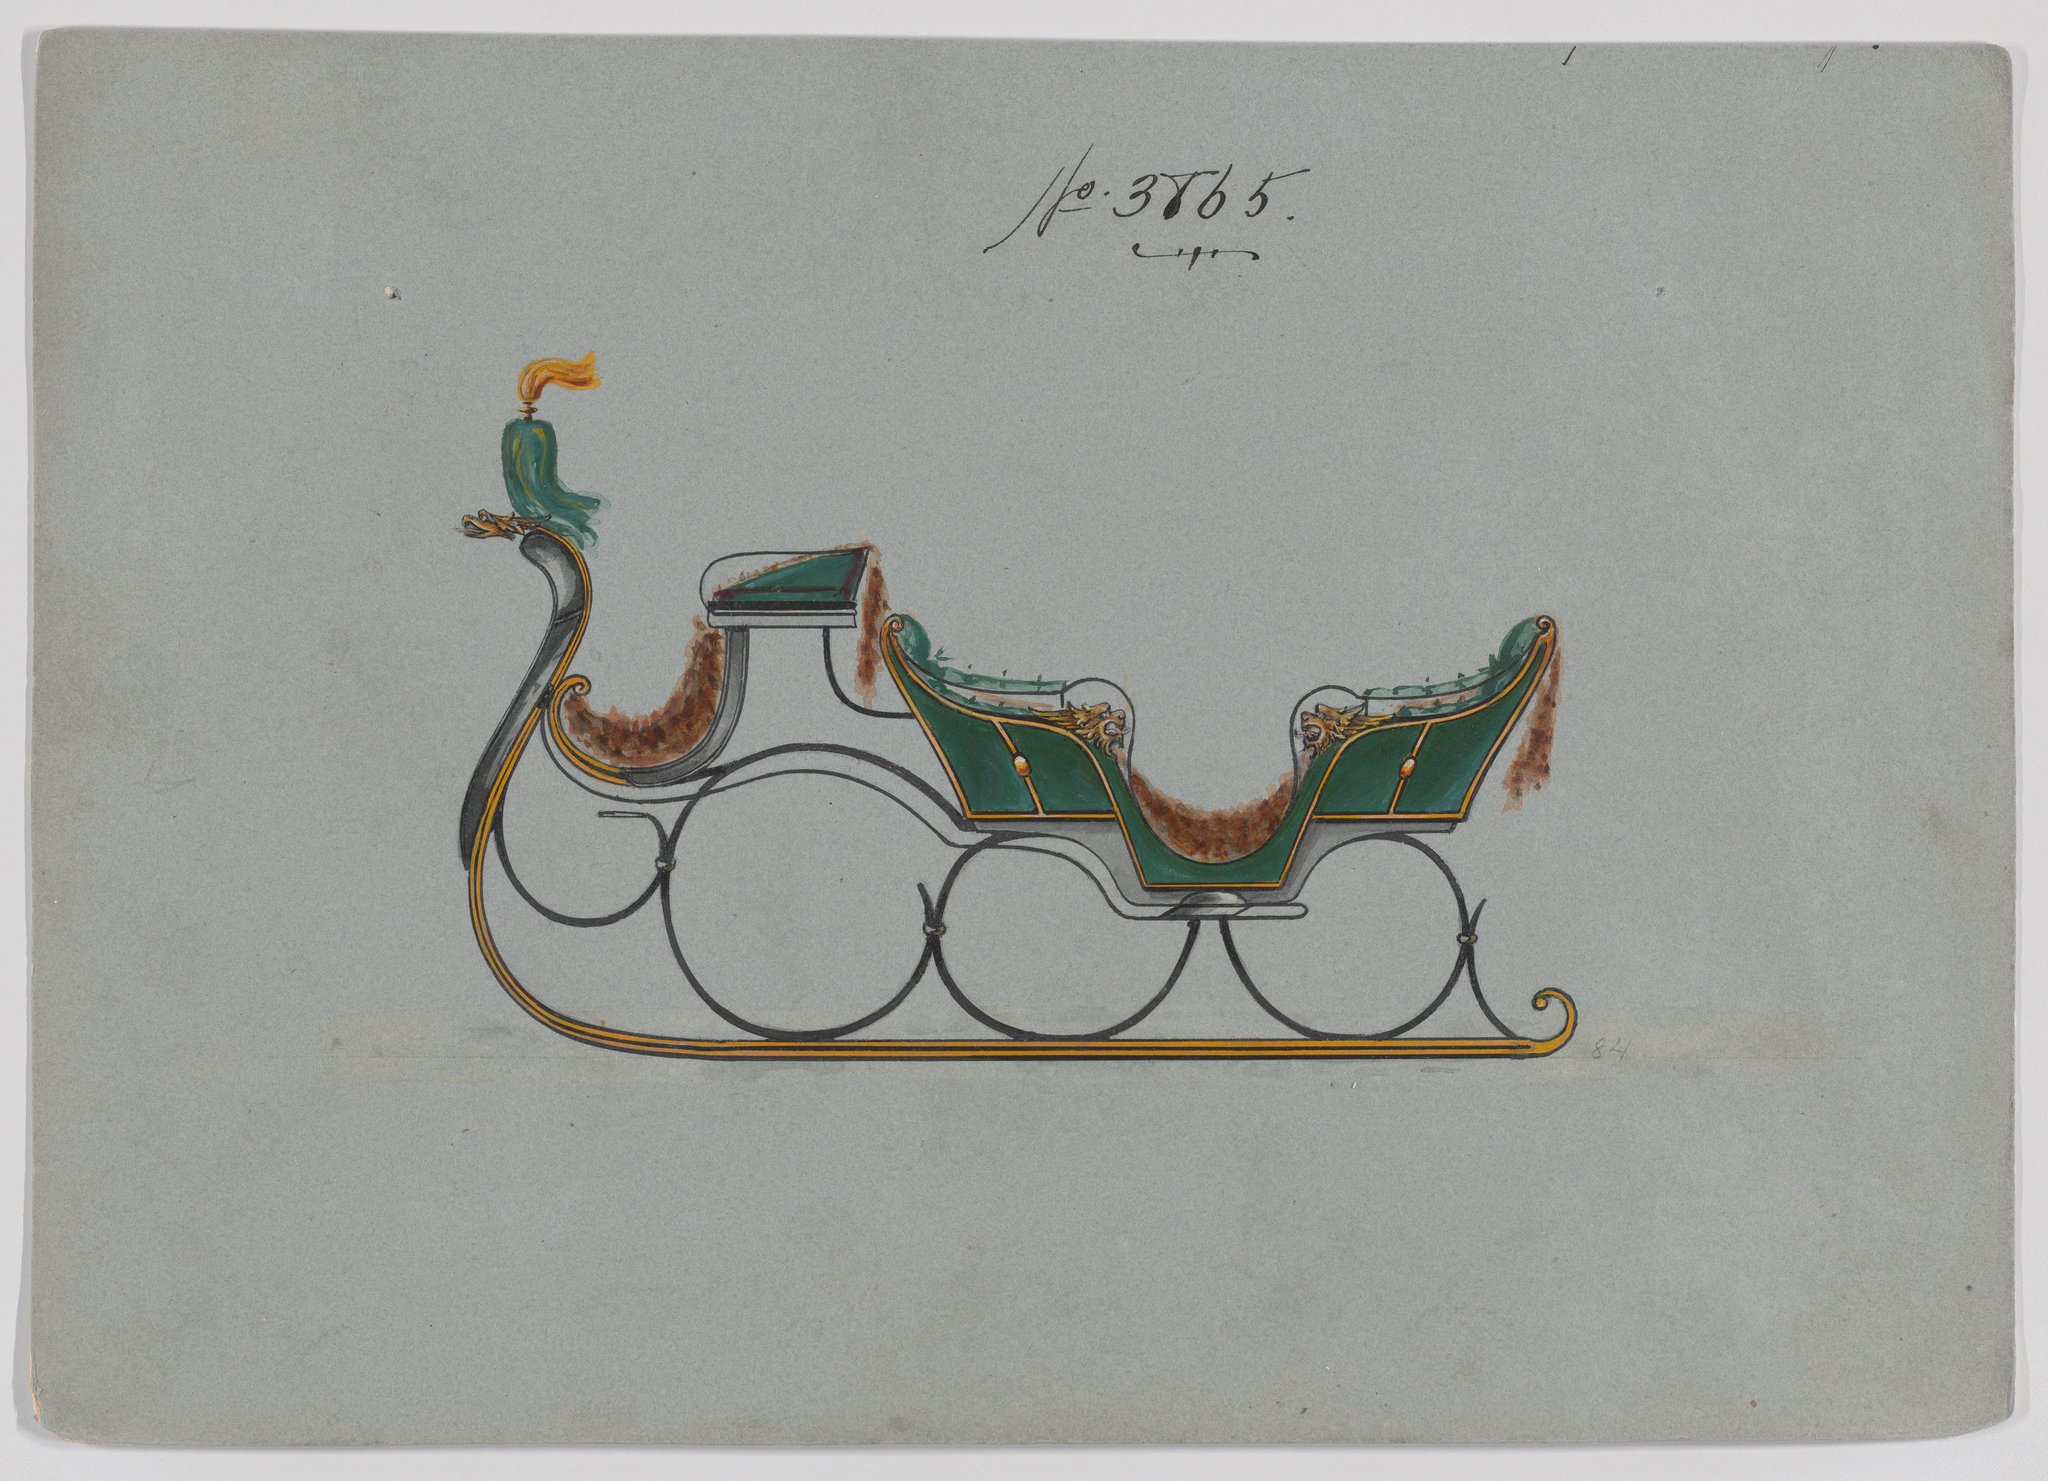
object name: drawing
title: Design for Vis-a-Vis Sleigh, no. 3865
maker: brewster & co.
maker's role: manufacturer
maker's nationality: american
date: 1884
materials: gouache, gum arabic, ink, watercolor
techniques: pen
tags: sleighs